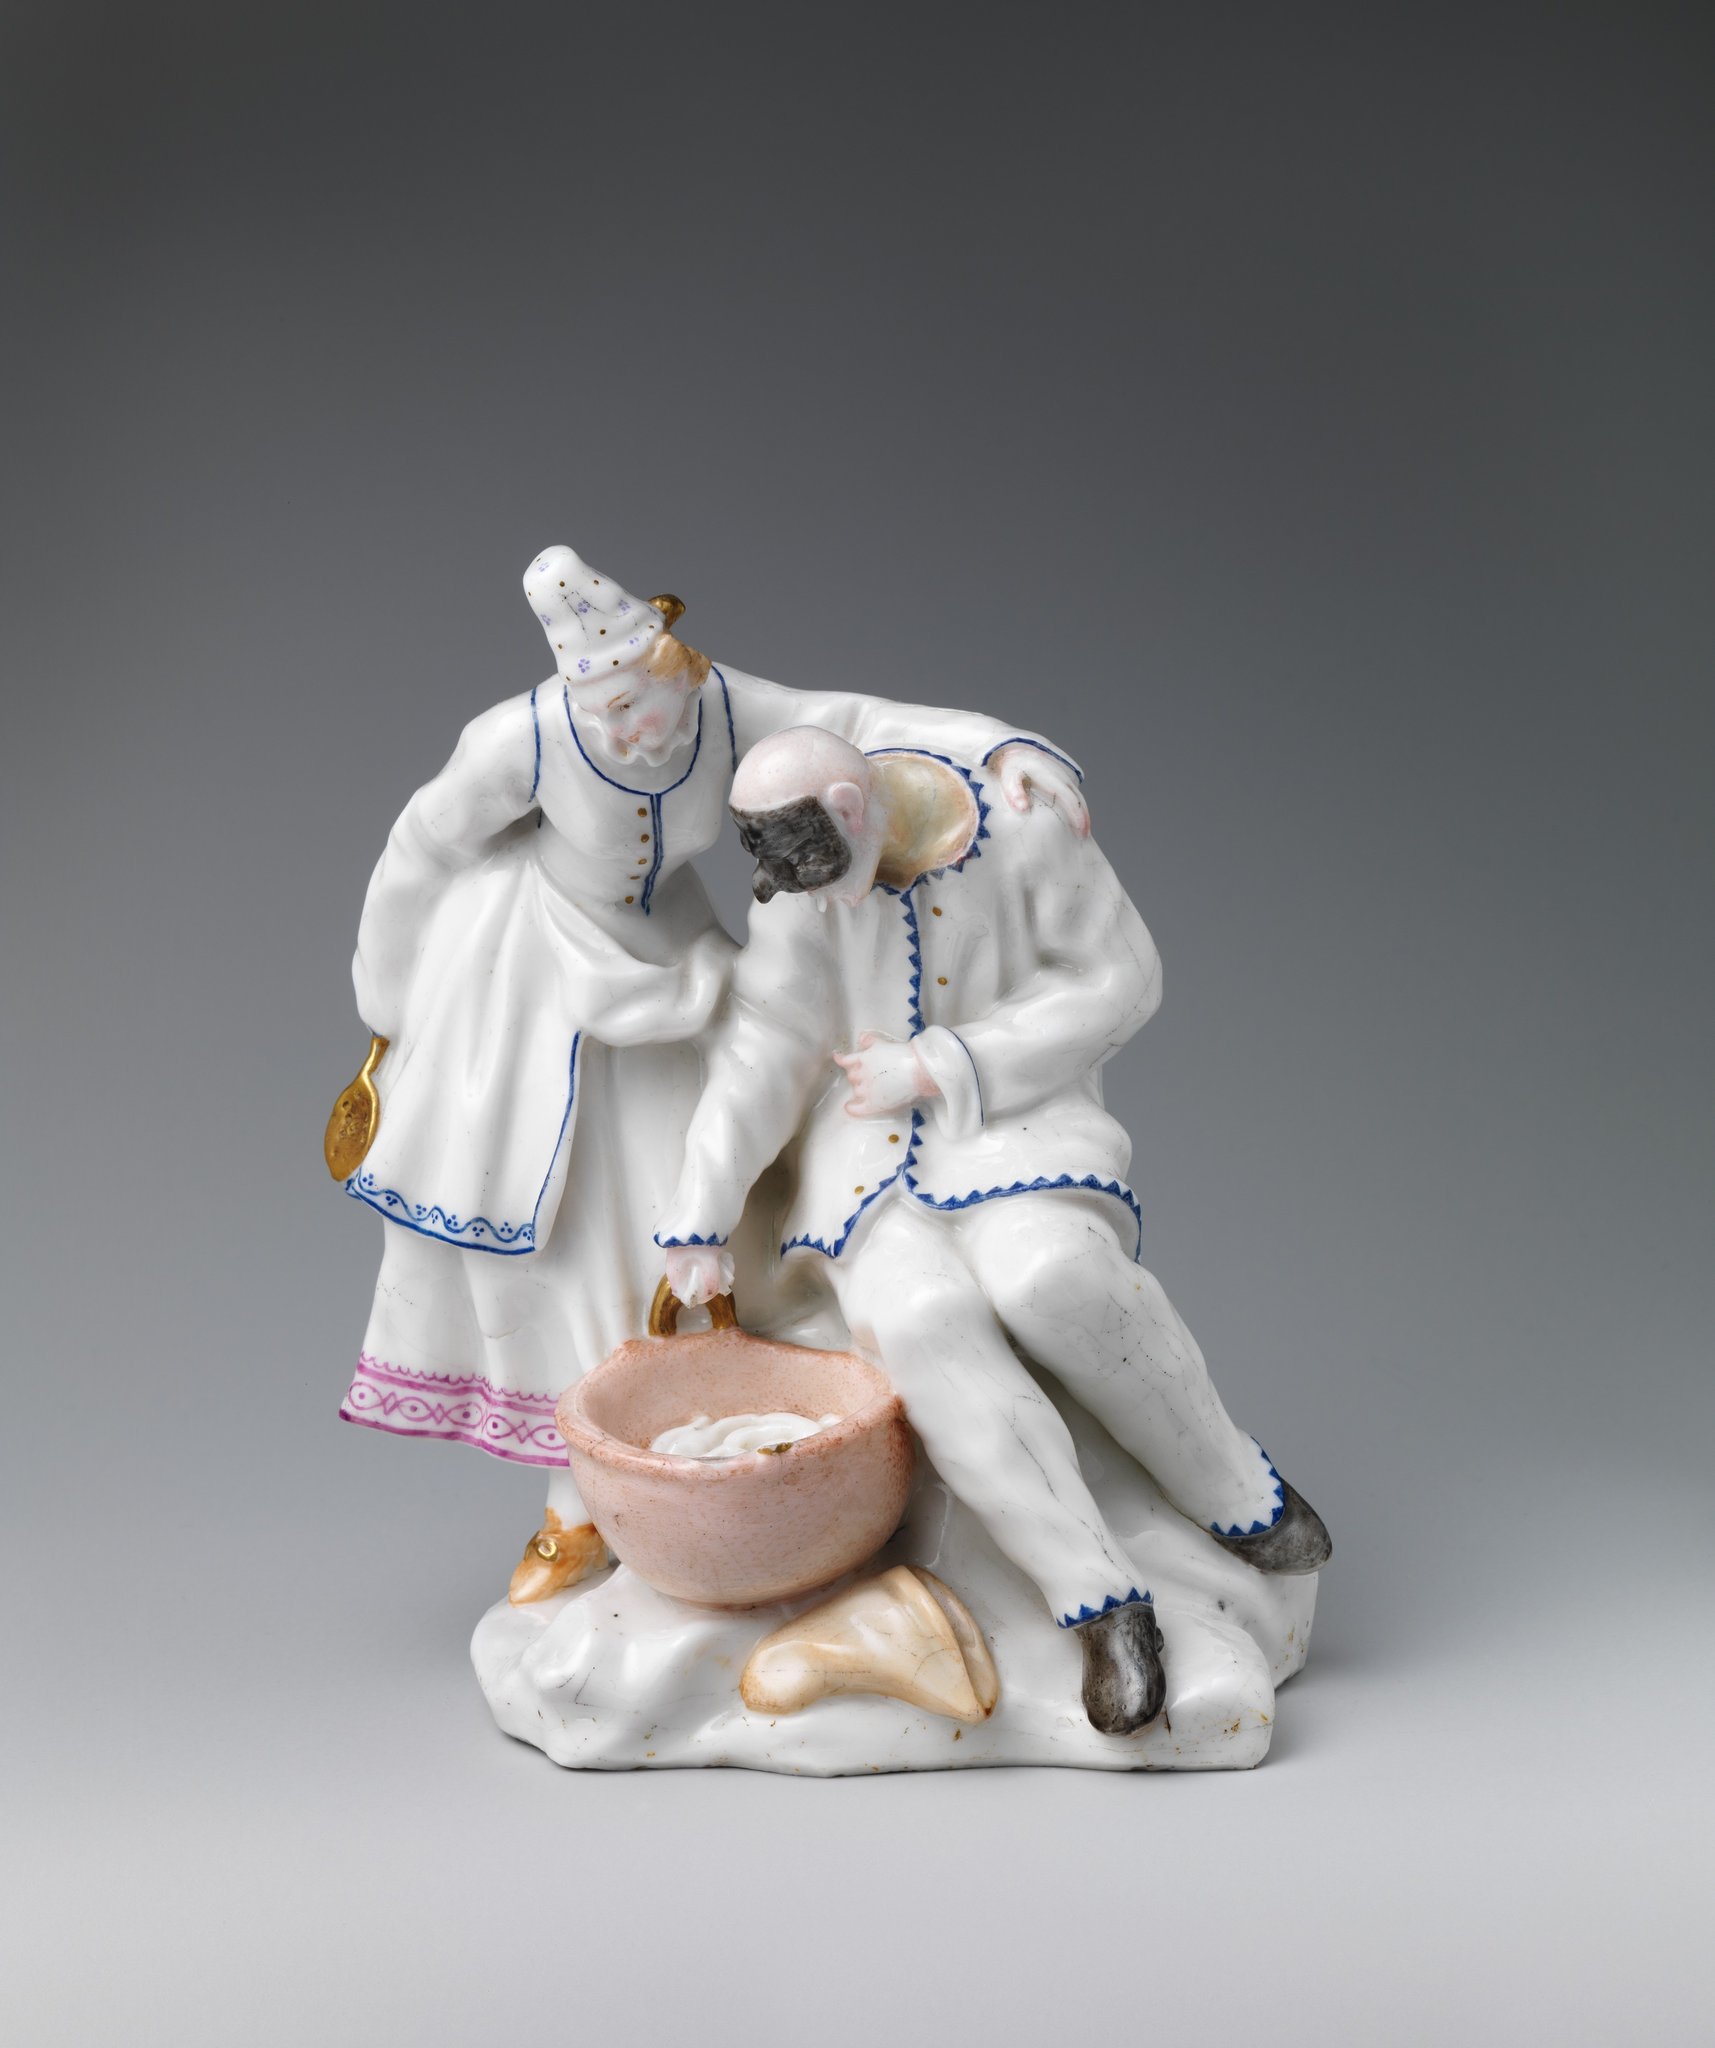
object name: figure group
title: The Spaghetti Eaters (Columbine and Pulcinella)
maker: capodimonte porcelain manufactory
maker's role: manufactory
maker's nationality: italian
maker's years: 1740-1759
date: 1750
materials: enamel, gold, soft paste porcelain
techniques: polychrome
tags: food,men,women,eating